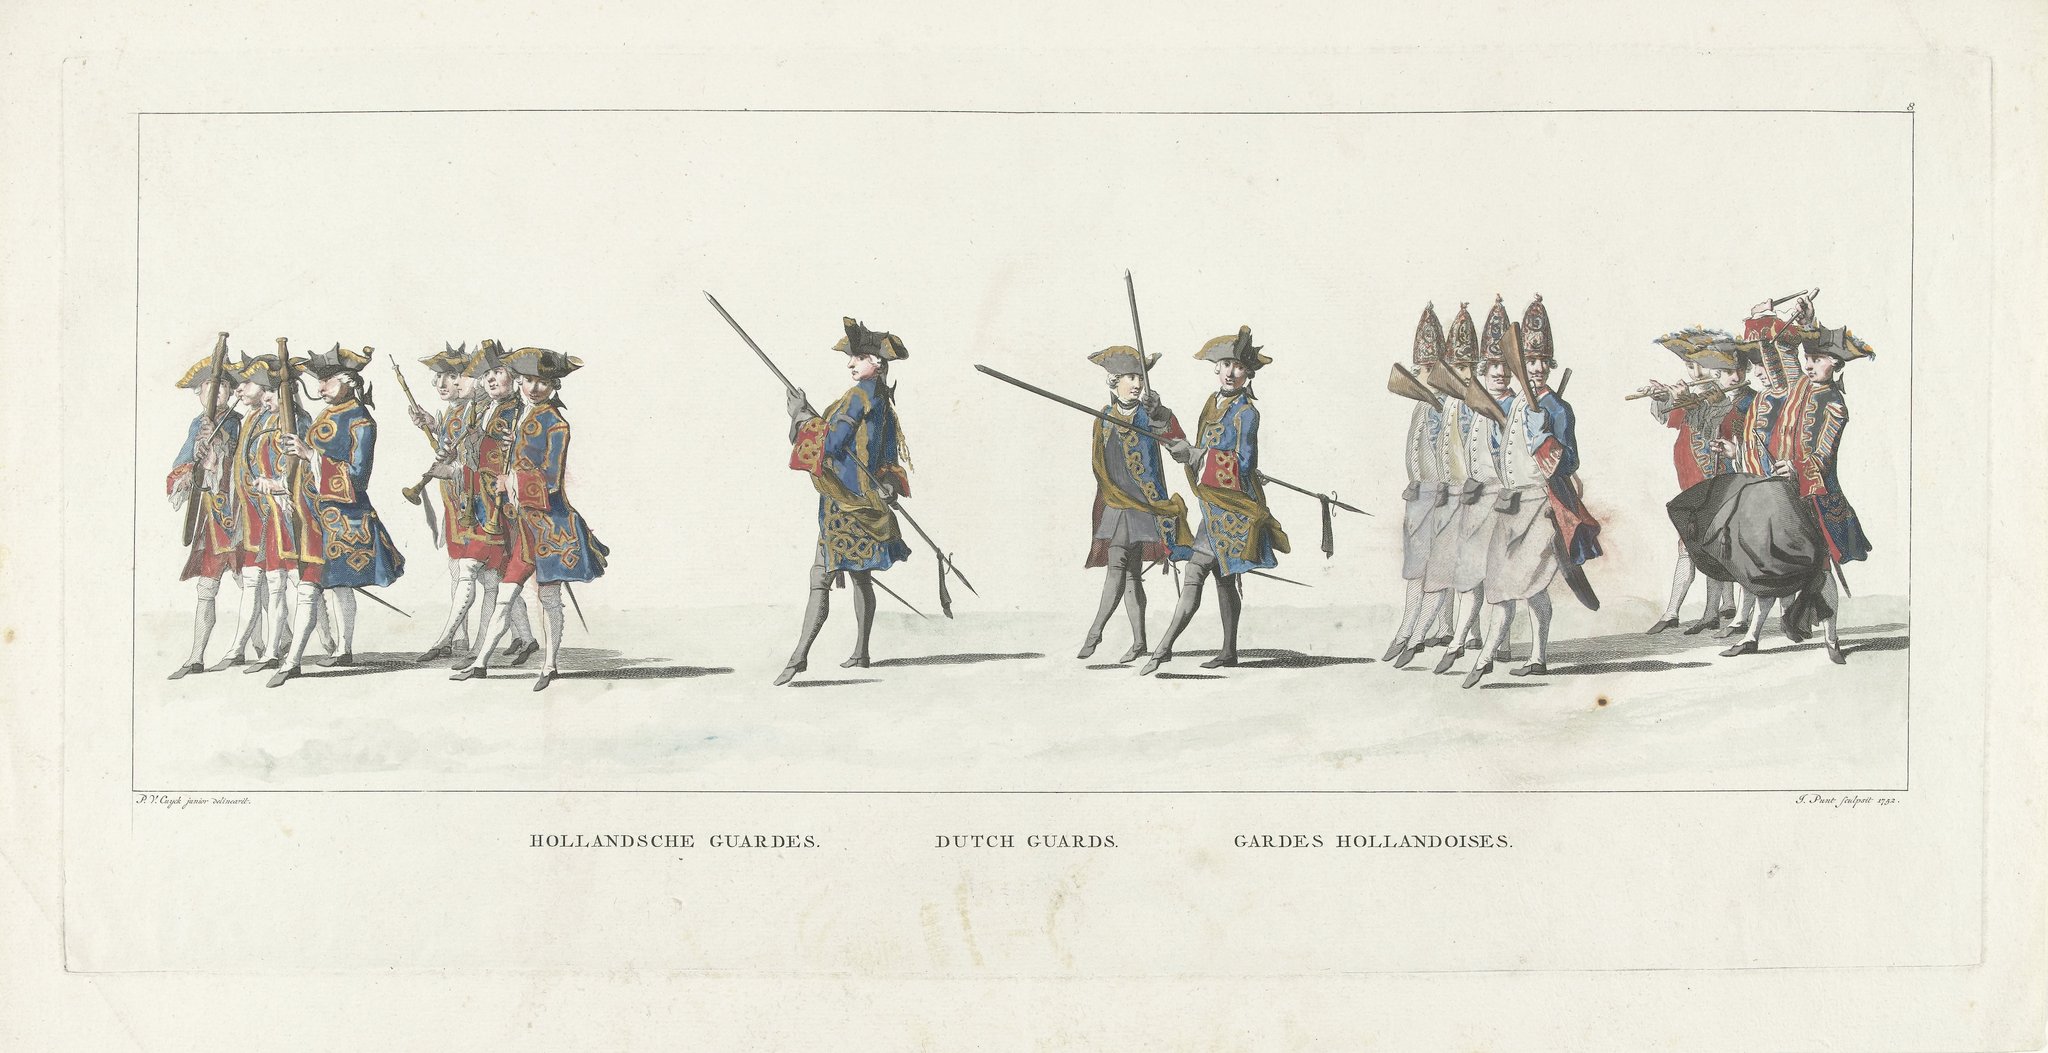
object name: print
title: Lyk-staetsie van zyne doorluchtigste Hoogheid den Heere Willem [IV] Carel Hendrik Friso, Prince van Orange en Nassau (...) gehouden den IV Februari 1752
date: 1752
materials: paper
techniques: engraving, etching, hand coloring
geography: northern netherlands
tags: willem iv (prins van oranje-nassau), military parade, pageant (+ infantry), military music, cortege, funeral procession, delft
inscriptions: collector's mark: Lugt 2228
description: De Hollandse Garde, voorafgegaan door muzikanten. In de marge het onderschrift in Nederlands, Frans en Engels. Onderdeel van een serie van 41 platen van de begrafenisstoet van stadhouder Willem IV te Delft op 4 februari 1752. Genummerd rechtsboven: 8.